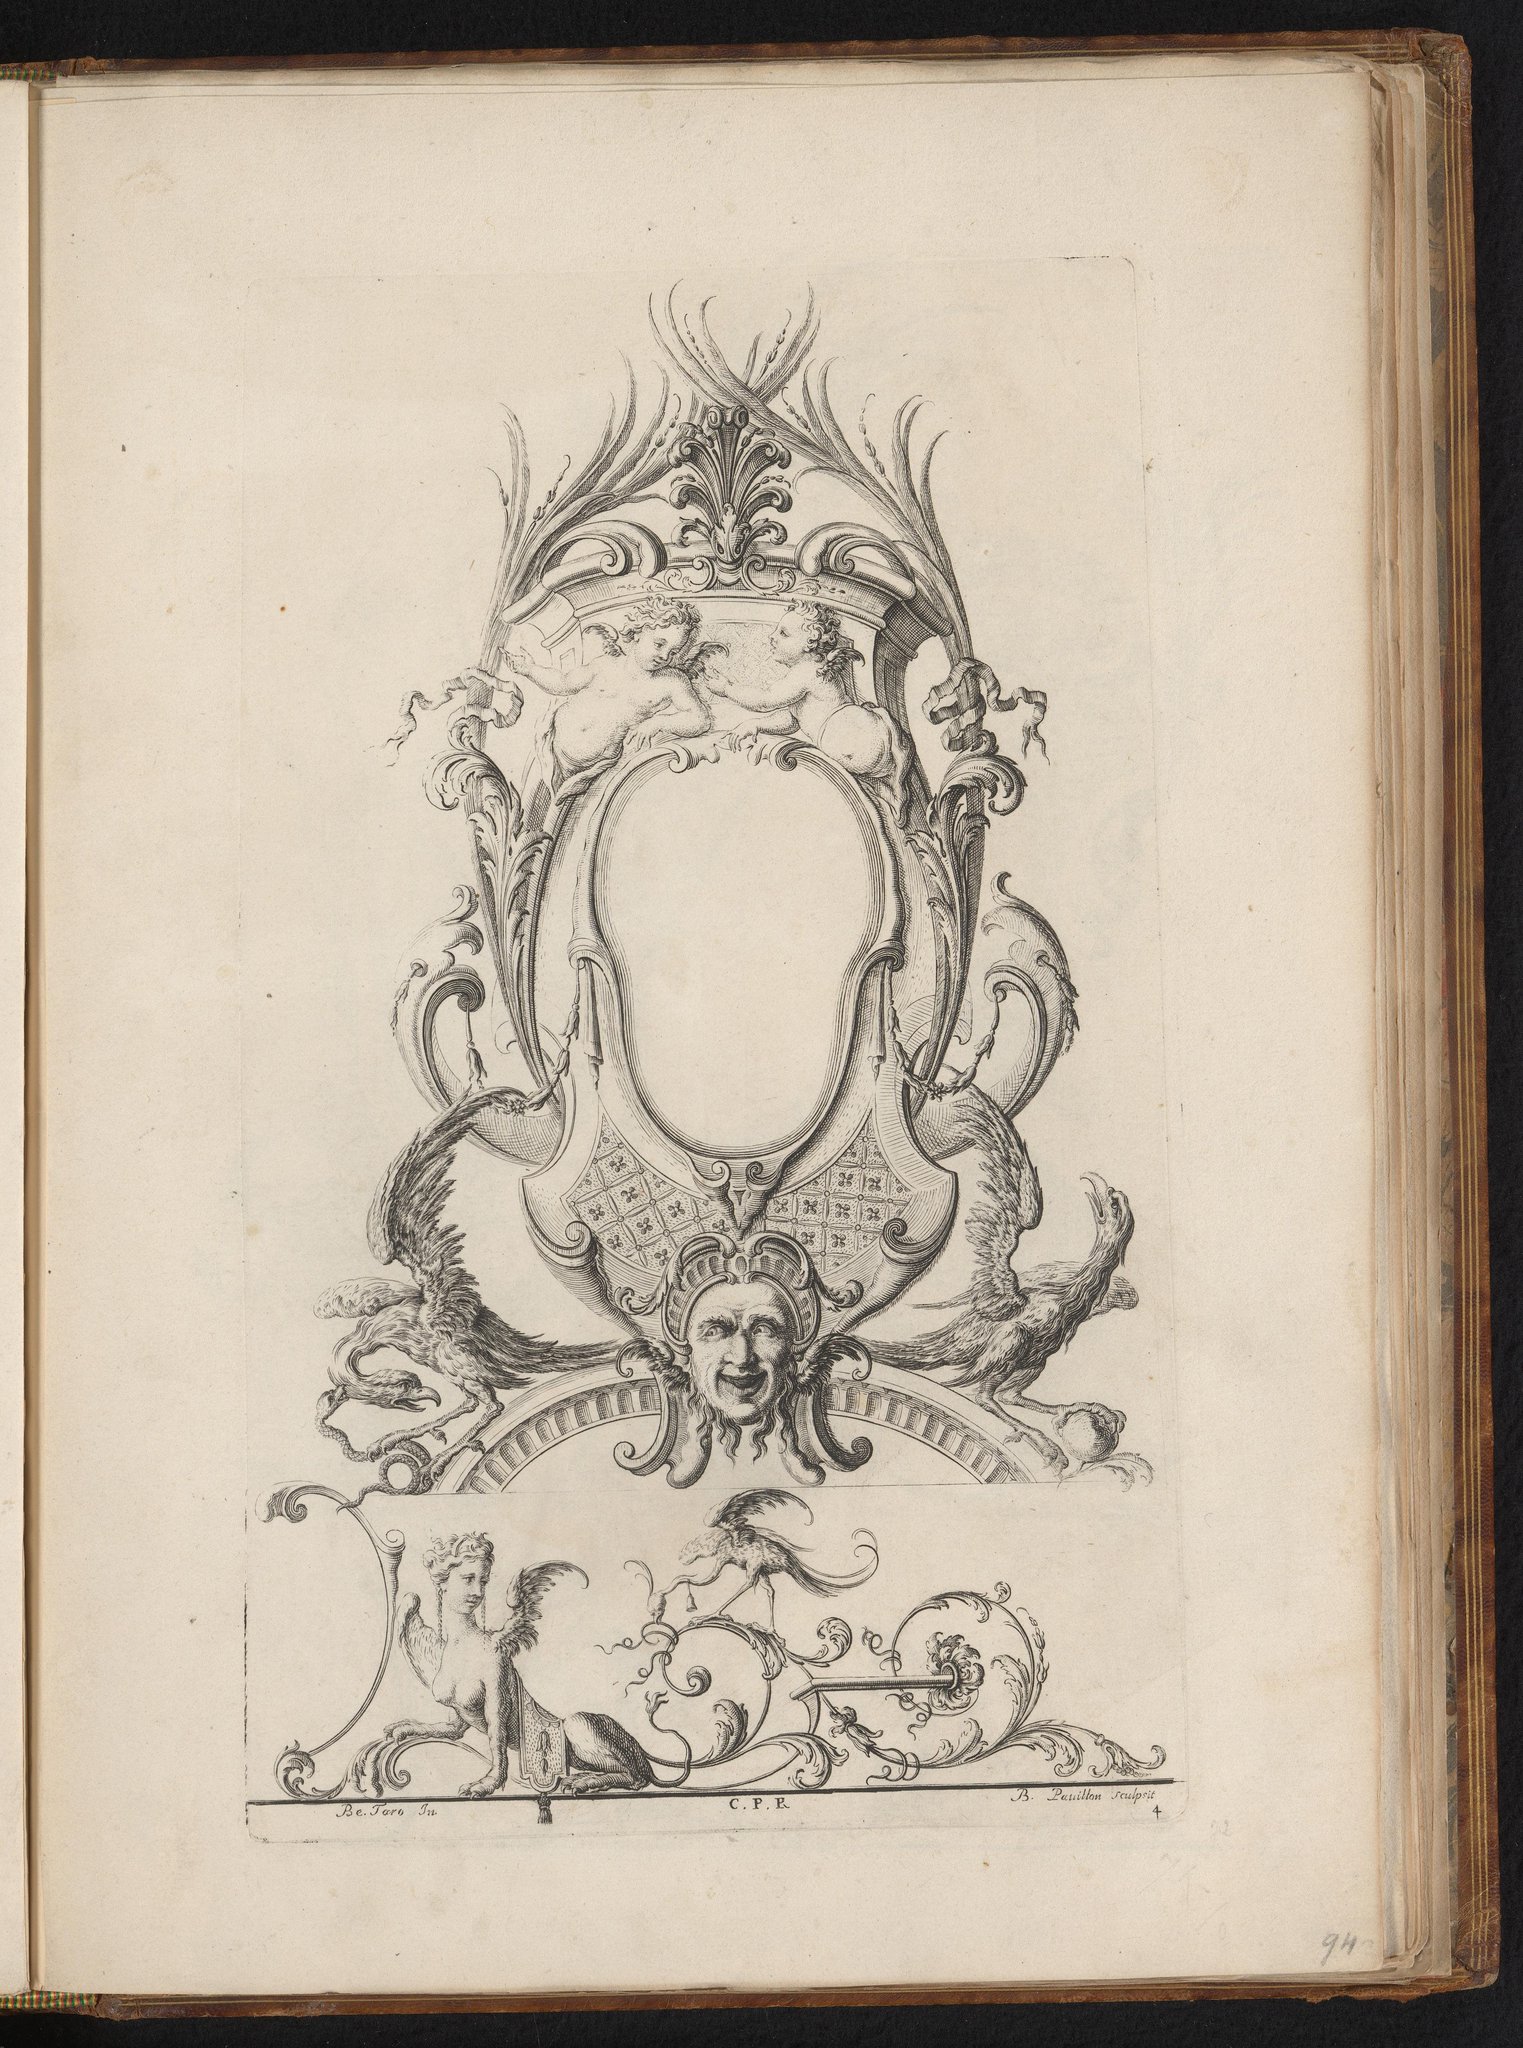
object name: album leaf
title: Cartouches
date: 1682-1729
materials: paper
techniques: etching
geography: france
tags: ornament ~ cartouche, mask, mascaron ~ ornament, cupids: 'amores', 'amoretti', 'putti'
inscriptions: collector's mark: Lugt 2228, collector's mark: Lugt 2760